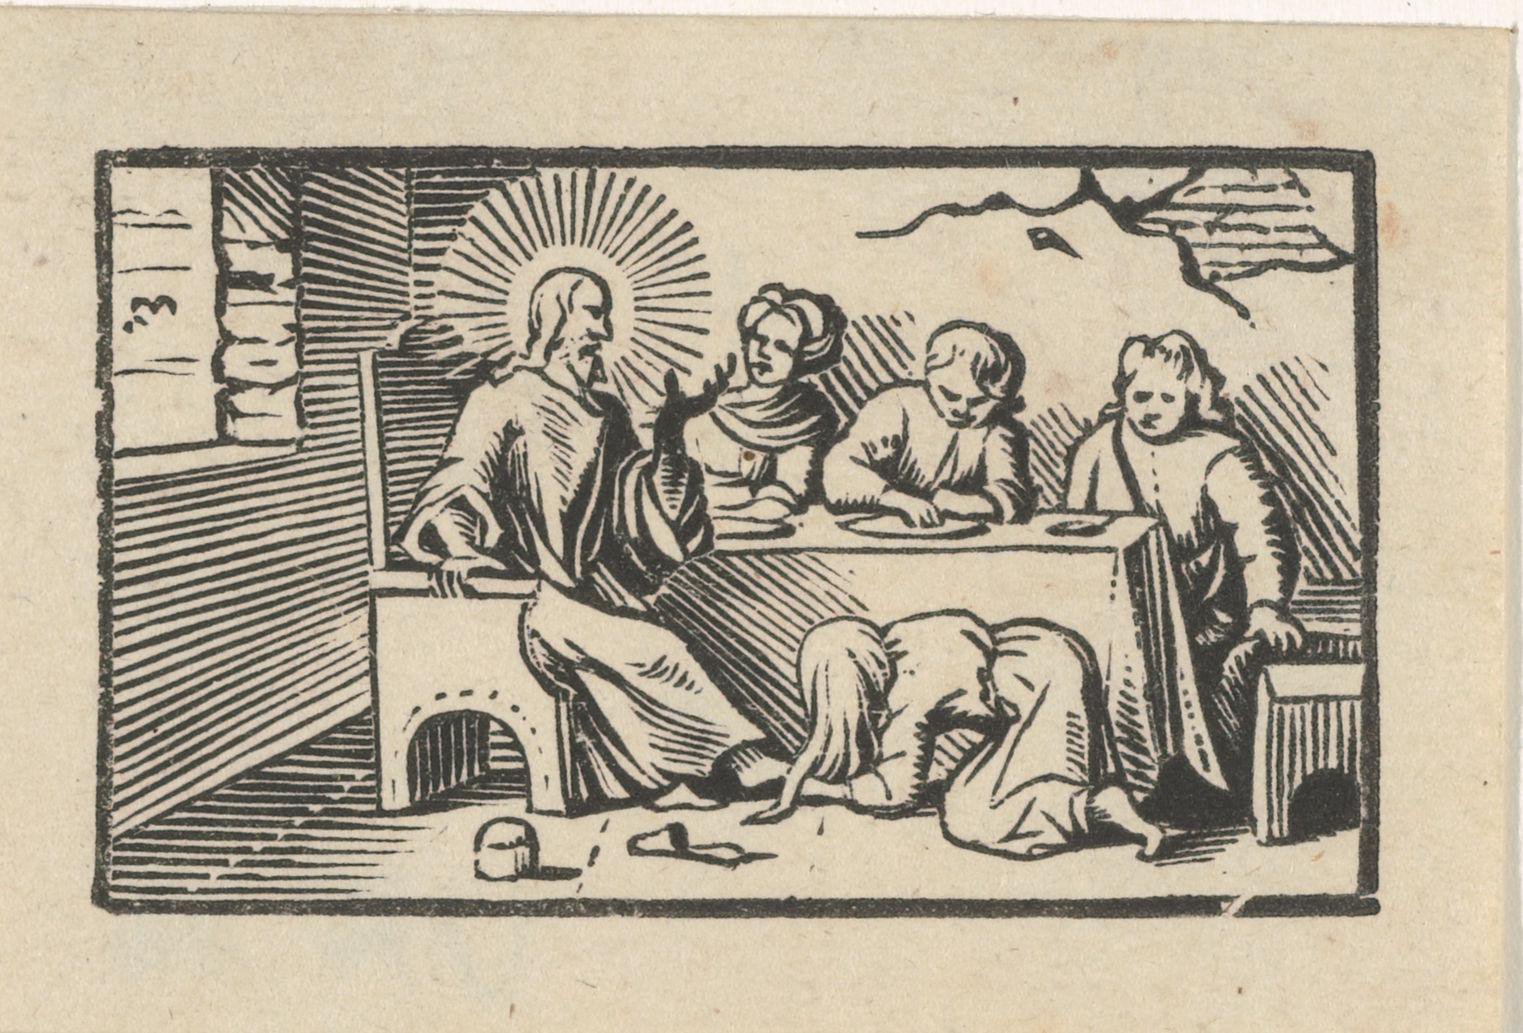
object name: print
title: Christus gezalfd door Maria Magdalena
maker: dirck de bray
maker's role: draughtsman, painter, print maker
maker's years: 1625-1694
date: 1635-1694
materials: paper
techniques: woodcut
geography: netherlands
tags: christ's feet are anointed by mary (magdalene)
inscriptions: collector's mark: Lugt 240